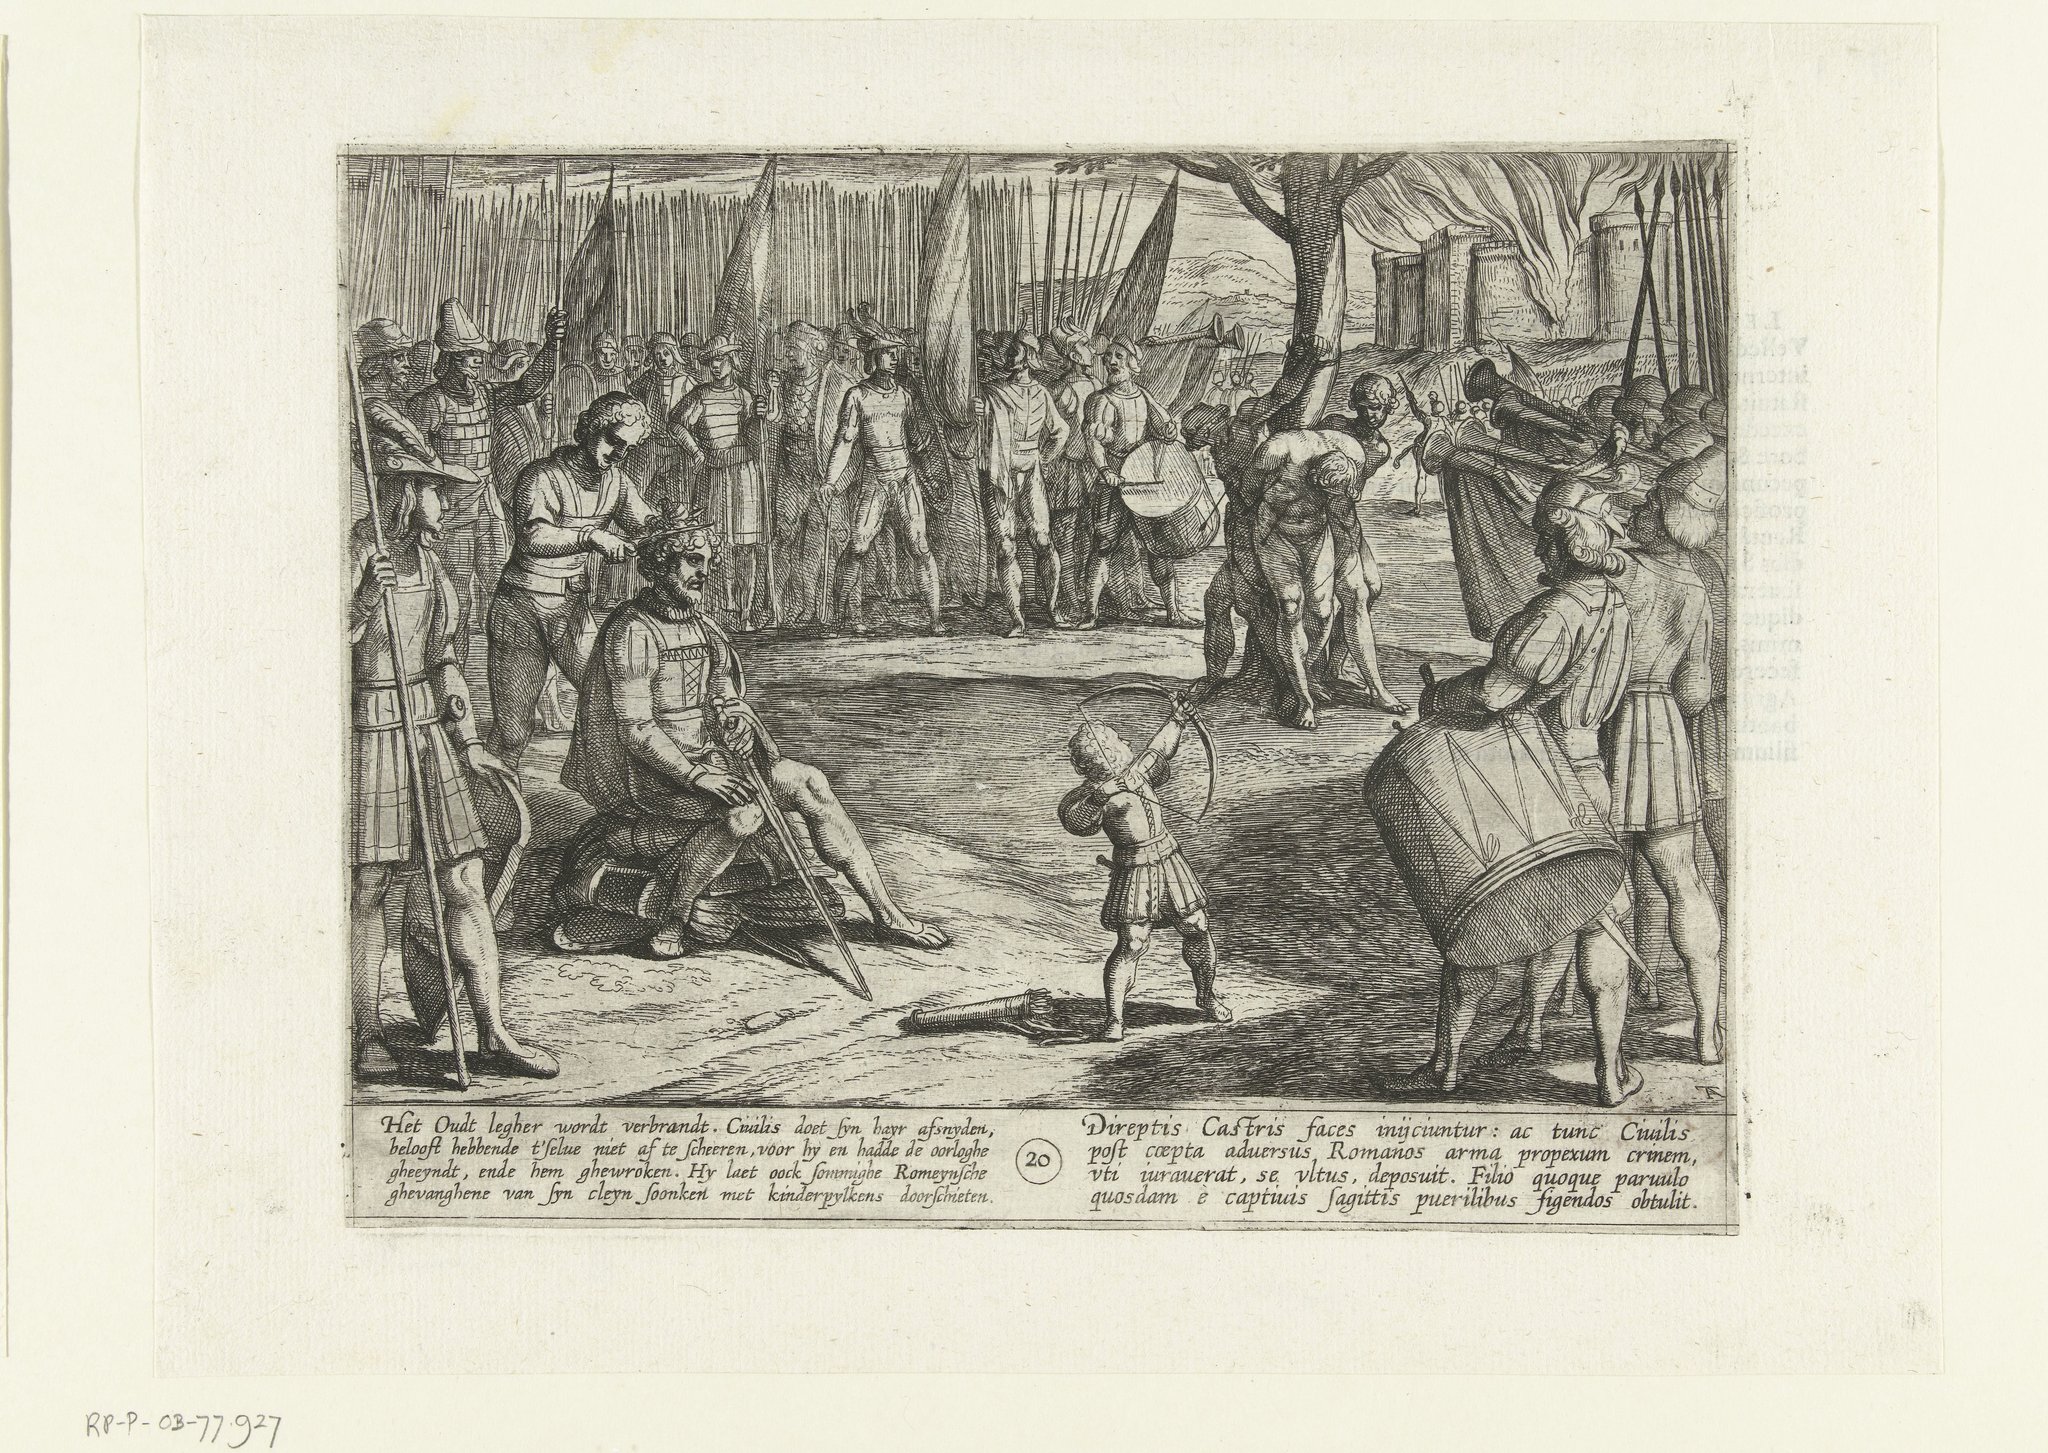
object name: history print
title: De Bataafse Opstand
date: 1612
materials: paper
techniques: etching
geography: italy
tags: hair-cutting, extinct, 'historical' peoples (with name), netherlands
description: Civilis laat zijn haren knippen volgens zijn belofte om de Romeinen te verslaan. Tevens laat hij zijn kleinzoon pijlen schieten op Romeinse gevangenen. Prent nummer 20 in de serie prenten over de Bataafse Opstand: Batavorum cum Romanis bellum / à Corn. Tacito lib. IV & V. : Hist. olim descriptum, figuris nunc aeneis expressum, auctore Othone Vaenio Lugdunobatava = De Batavische oft oude Hollandtsche oorloghe teghen de Romeynen. Otto Vaenius, Antwerpen 1612. Onderaan twee verzen van vier regels in het Nederlands en in het Latijn. Op de achterzijde tekst in het Latijn.